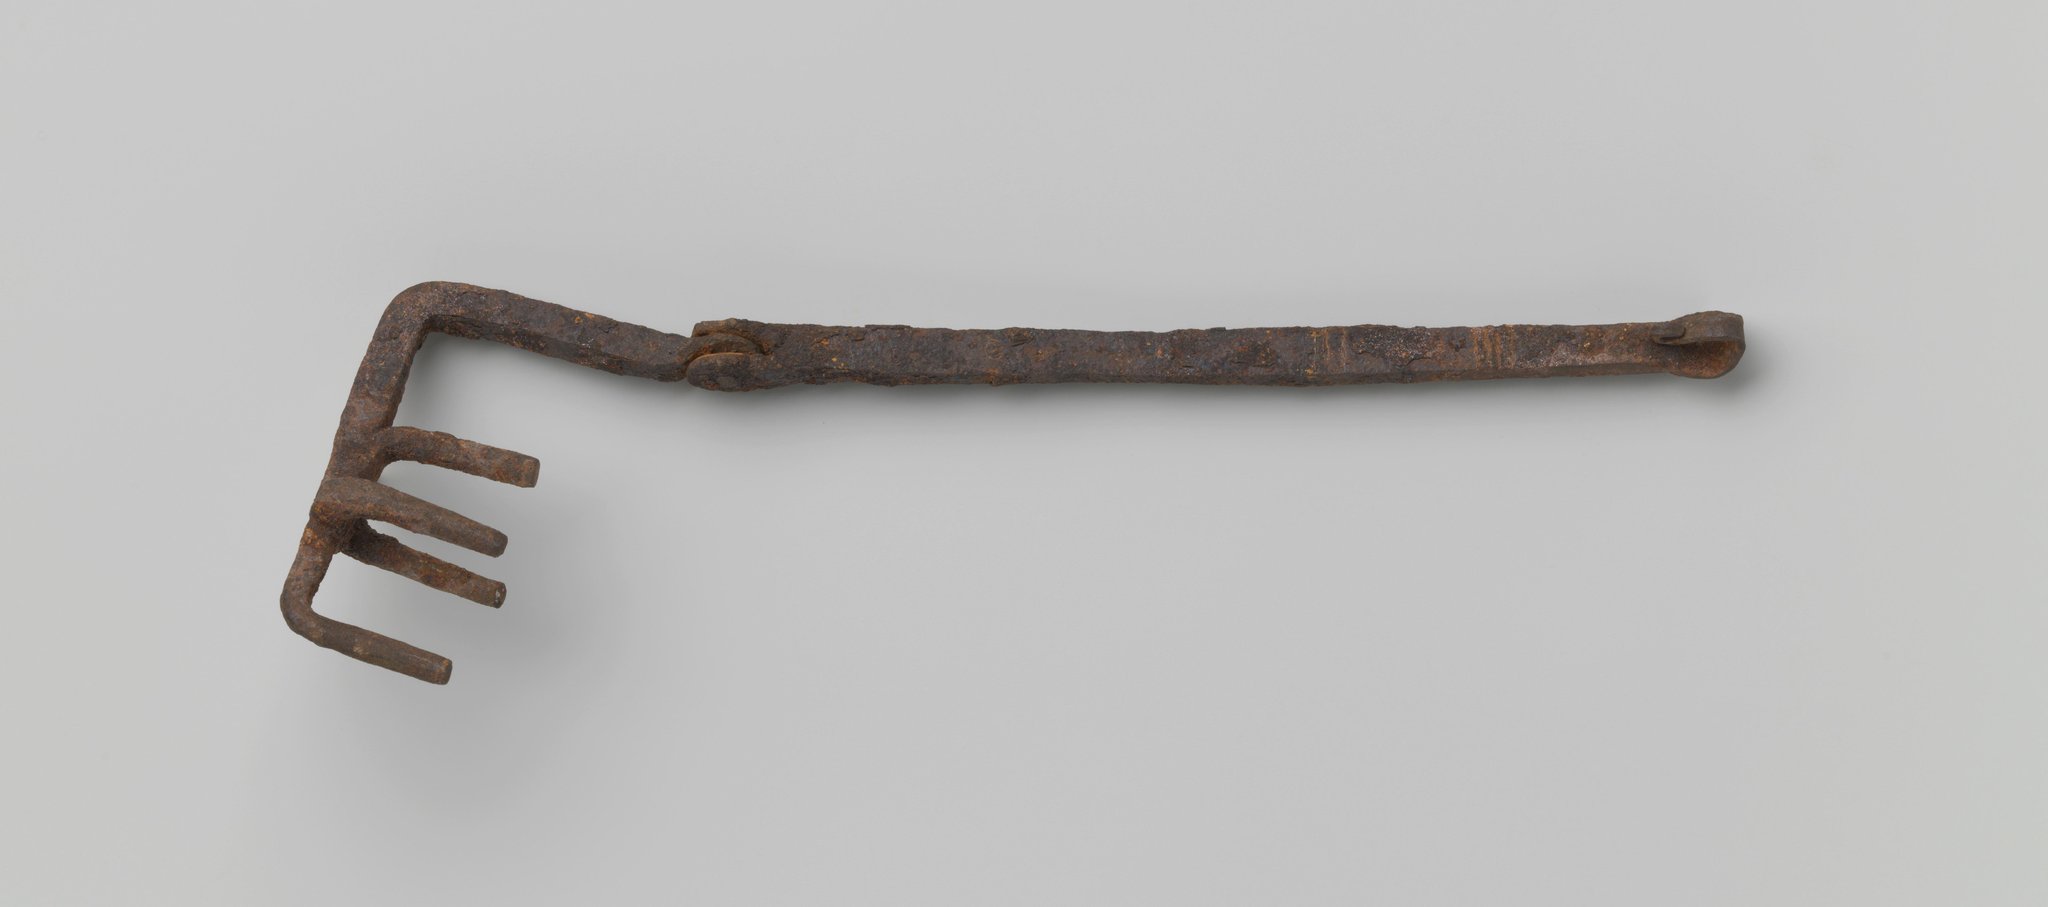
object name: hefsleutel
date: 1400-1950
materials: iron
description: Hefsleutel bestaande uit een lange vierzijdige steel die aan het einde in een rechthoek ombuigt en in een viertandige baard, gelijkend op een vogelklauw, eindigt. Onderaan de steel bevindt zich een scharnier. De steel is bovenaan tot een oogje omgebogen.